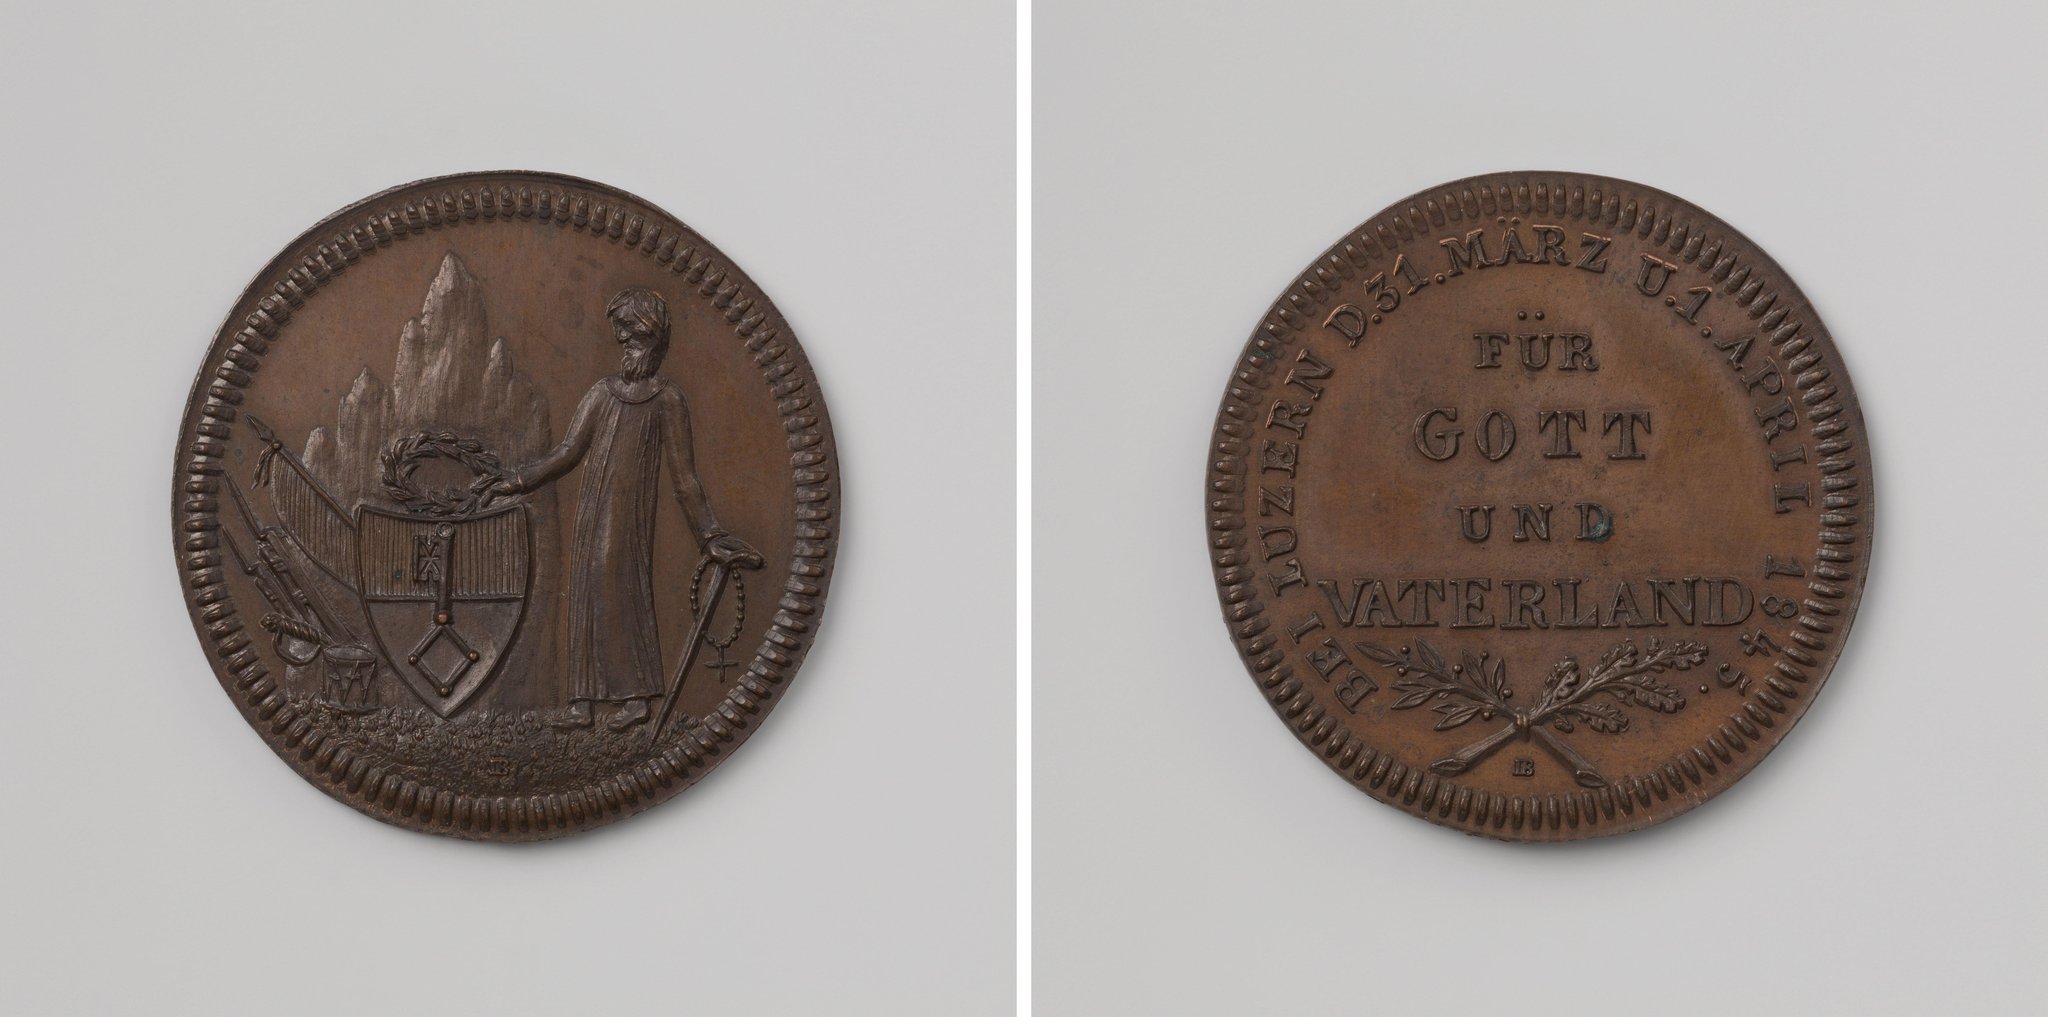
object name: honorary medal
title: Oberwaldens schuttersfeest bij Luzern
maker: johann caspar bruppacher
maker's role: mintmaster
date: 1845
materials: bronze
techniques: striking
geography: lucerne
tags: luzern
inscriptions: circumscription: ‘BEI LUZERN D . 31 . MÄRZ U . 1 . APRIL 1845 .’, signature: ‘IB’, inscription: ‘FÜR / GOTT / UND / VATERLAND’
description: Bronzen penning. Voorzijde: man met stok en rozenkrans in linkerhand houdt met rechterhand lauwerkrans boven wapenschild van Oberwalden, staande voor vaandel, geweren en trom; op achtergrond: bertgtop binnen geribbelde rand. Keerzijde: opschrift boven gekruiste lauwer- en eiketak binnen omschrift en geribbelde rand